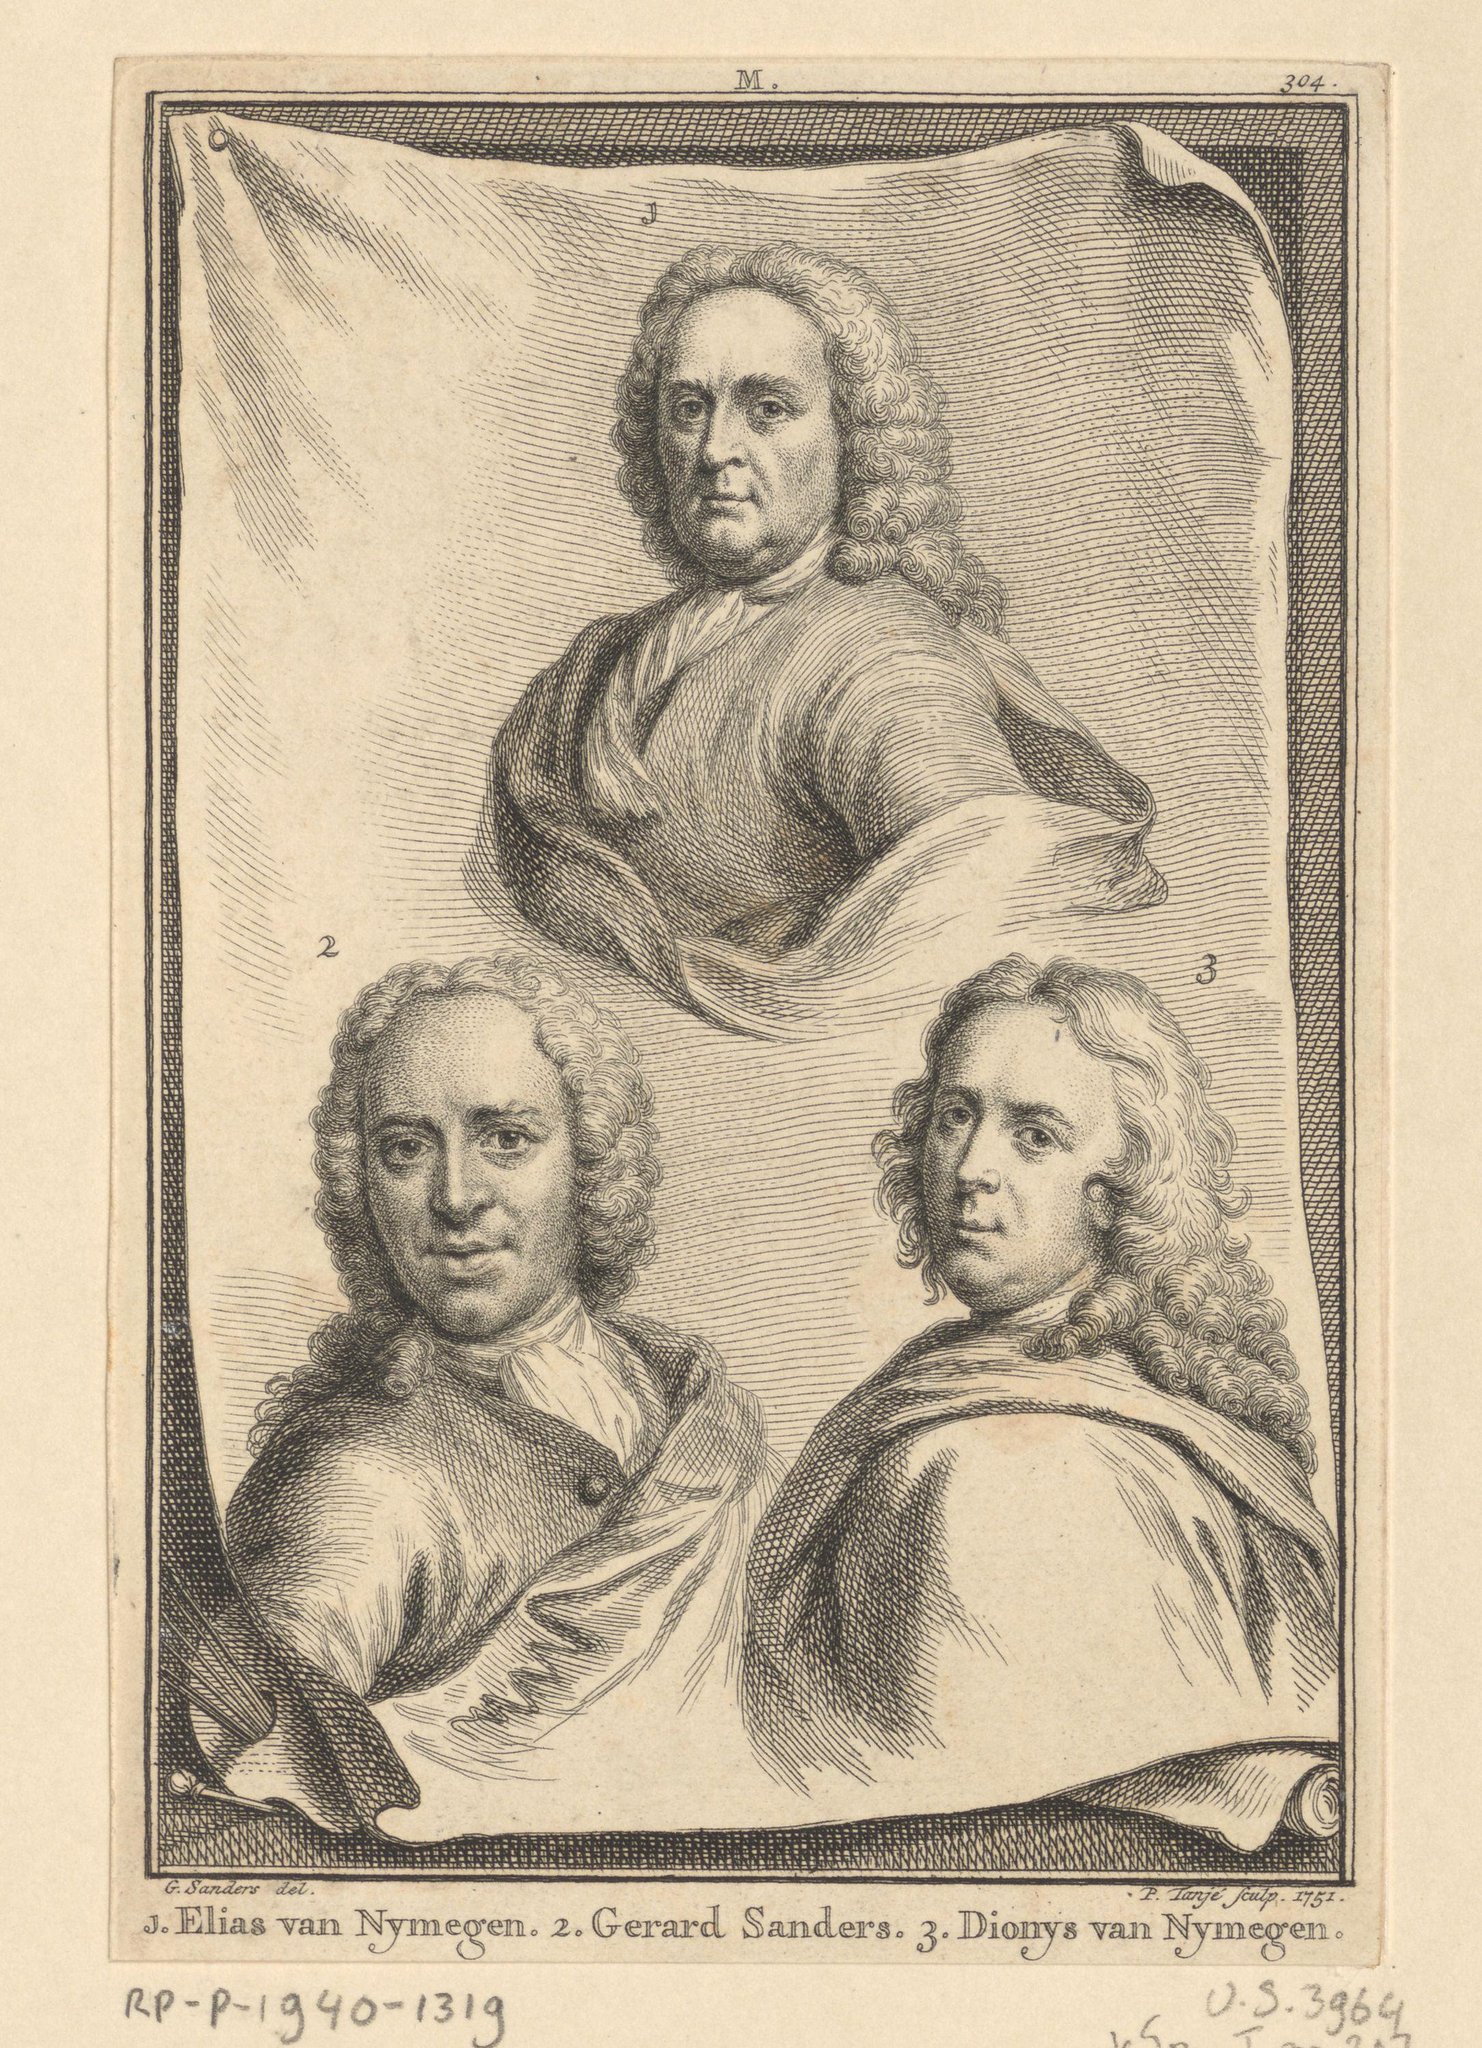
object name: print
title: Portret van Elias van Nijmegen, Gerard Sanders en Dionys van Nijmegen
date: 1751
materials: paper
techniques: engraving, etching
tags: draughtsman, dionys van nijmegen, gerard sanders, nijmegen, elias van nijmegen, historical persons, portrait, self-portrait of artist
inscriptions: collector's mark: Lugt 2228, collector's mark: Lugt 2760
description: Prent waarschijnlijk uit: Gool, Johan van. De nieuwe schouburg der nederlantsche kunstschilders en schilderessen (...). Den Haag: Johan van Gool, 1751, dl. 2.